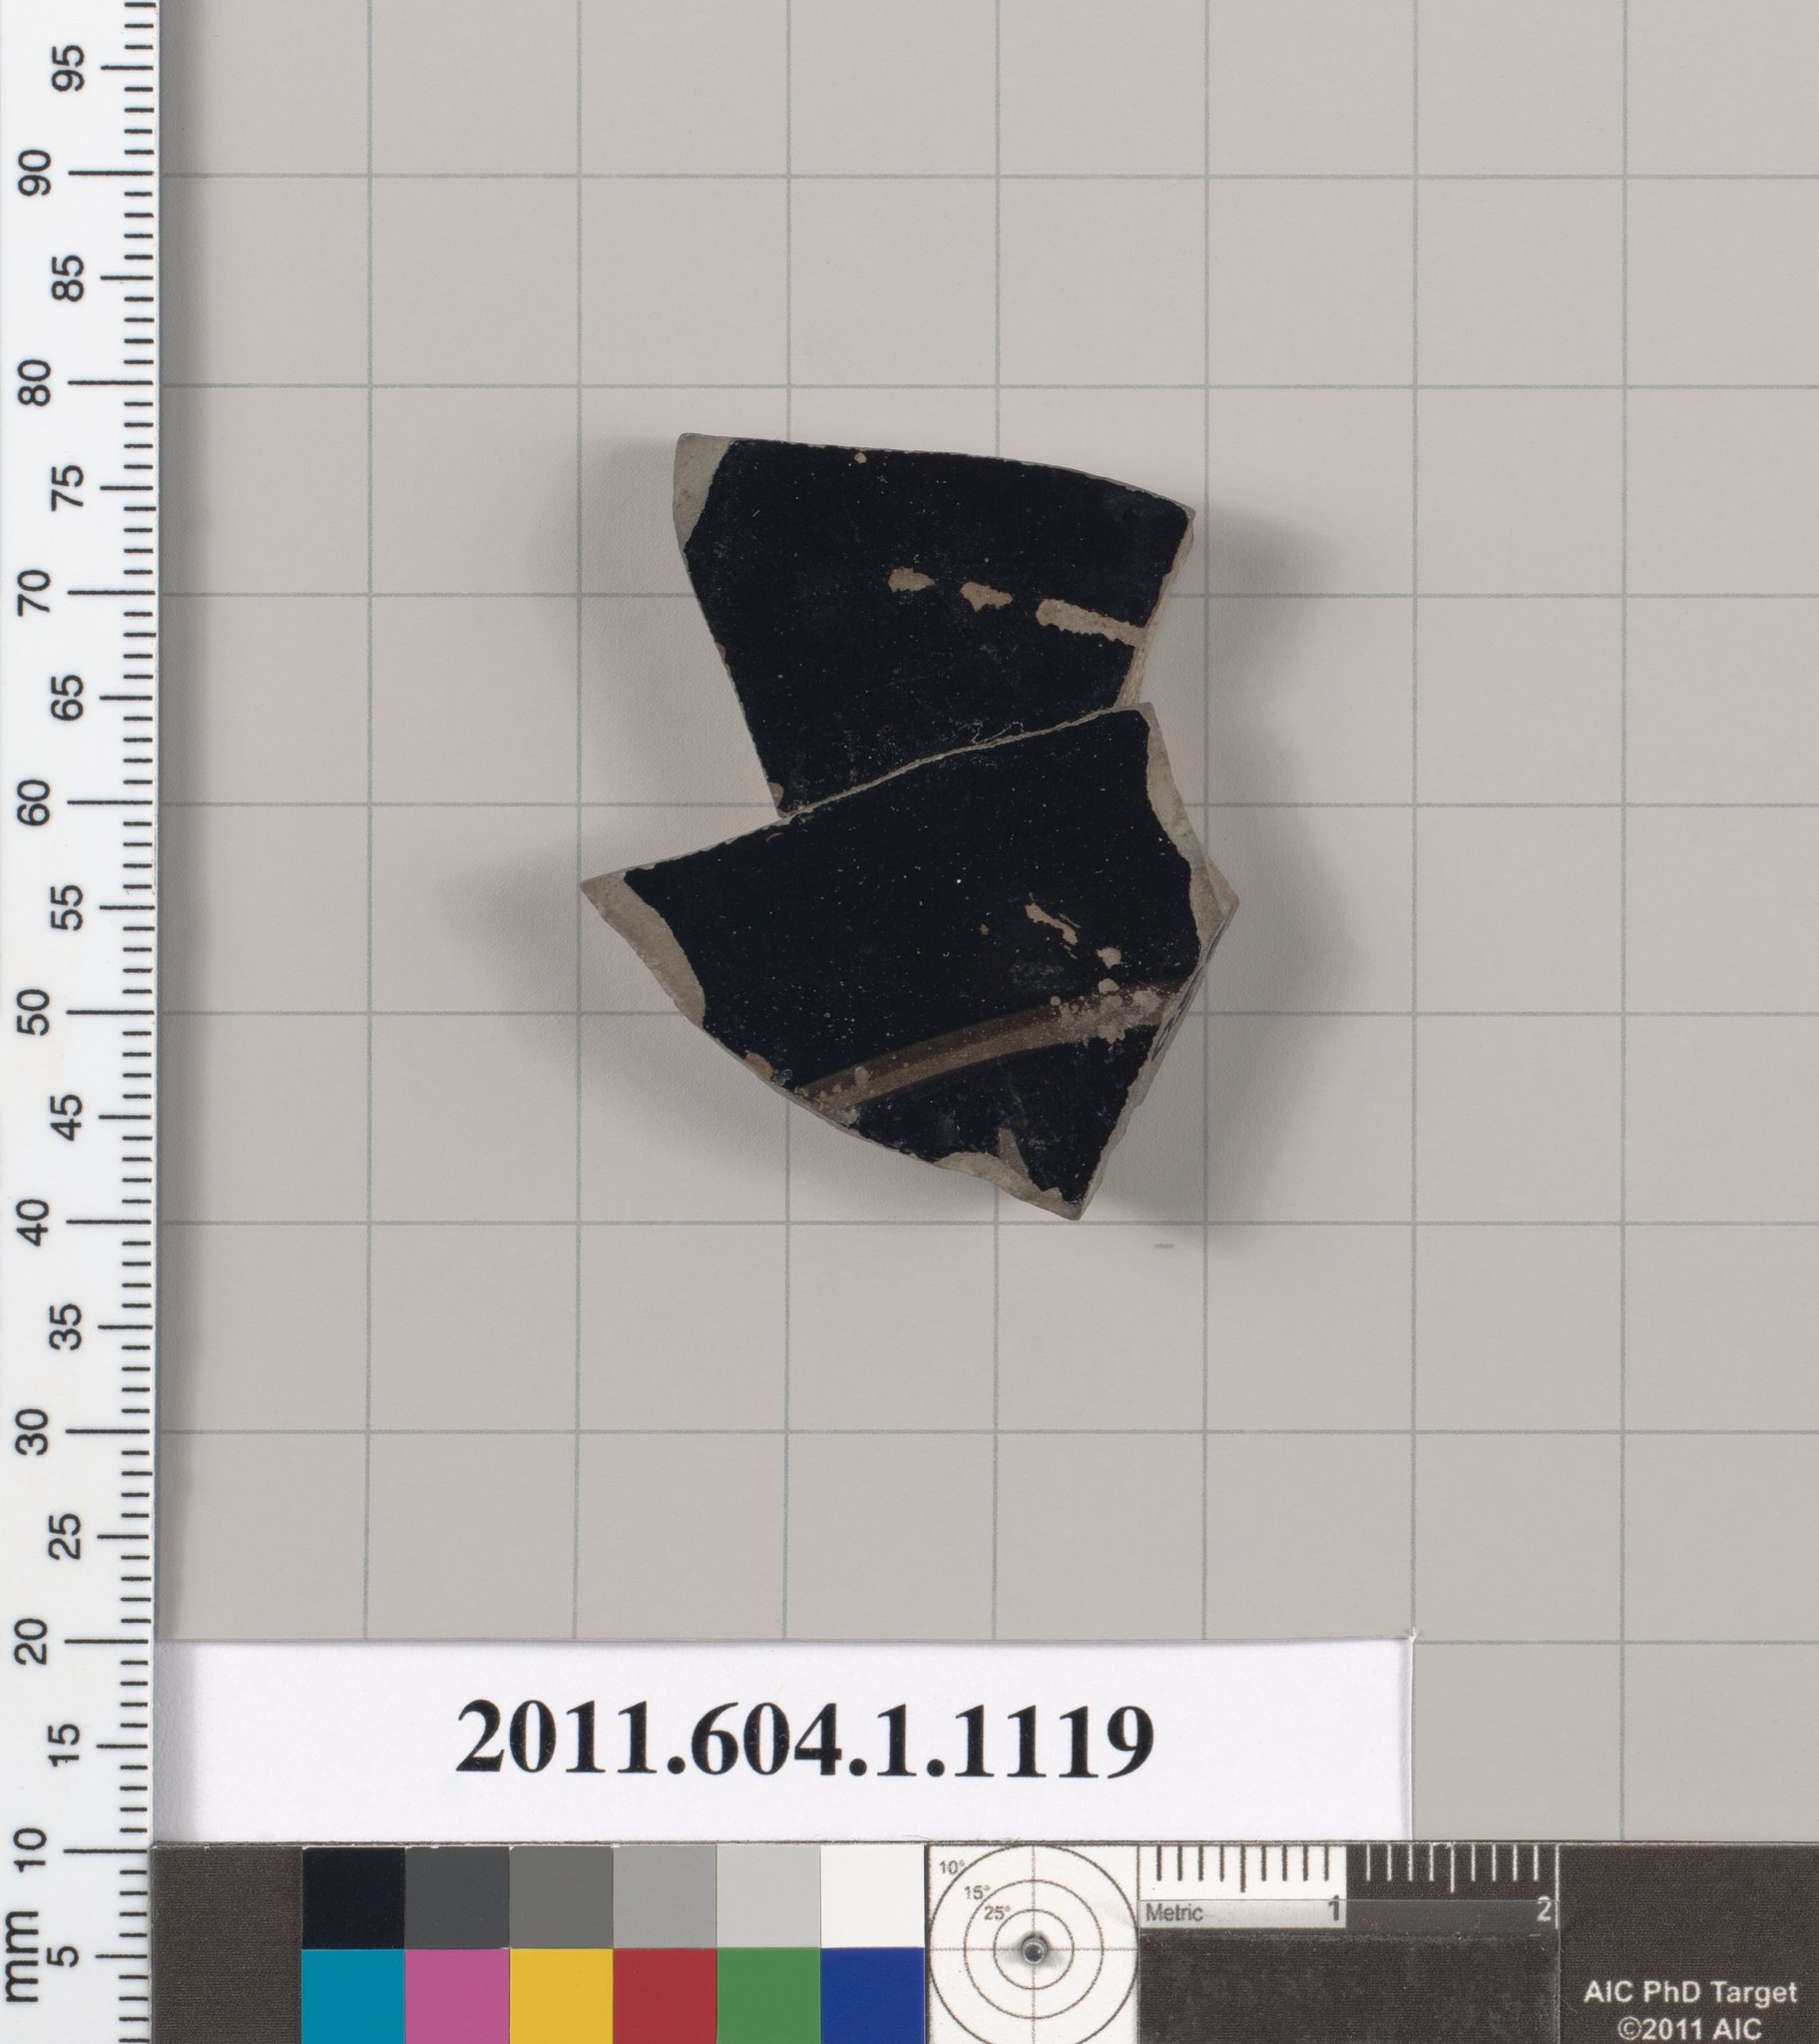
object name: kylix fragment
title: Terracotta fragment of a kylix (drinking cup)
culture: greek, attic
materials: terracotta